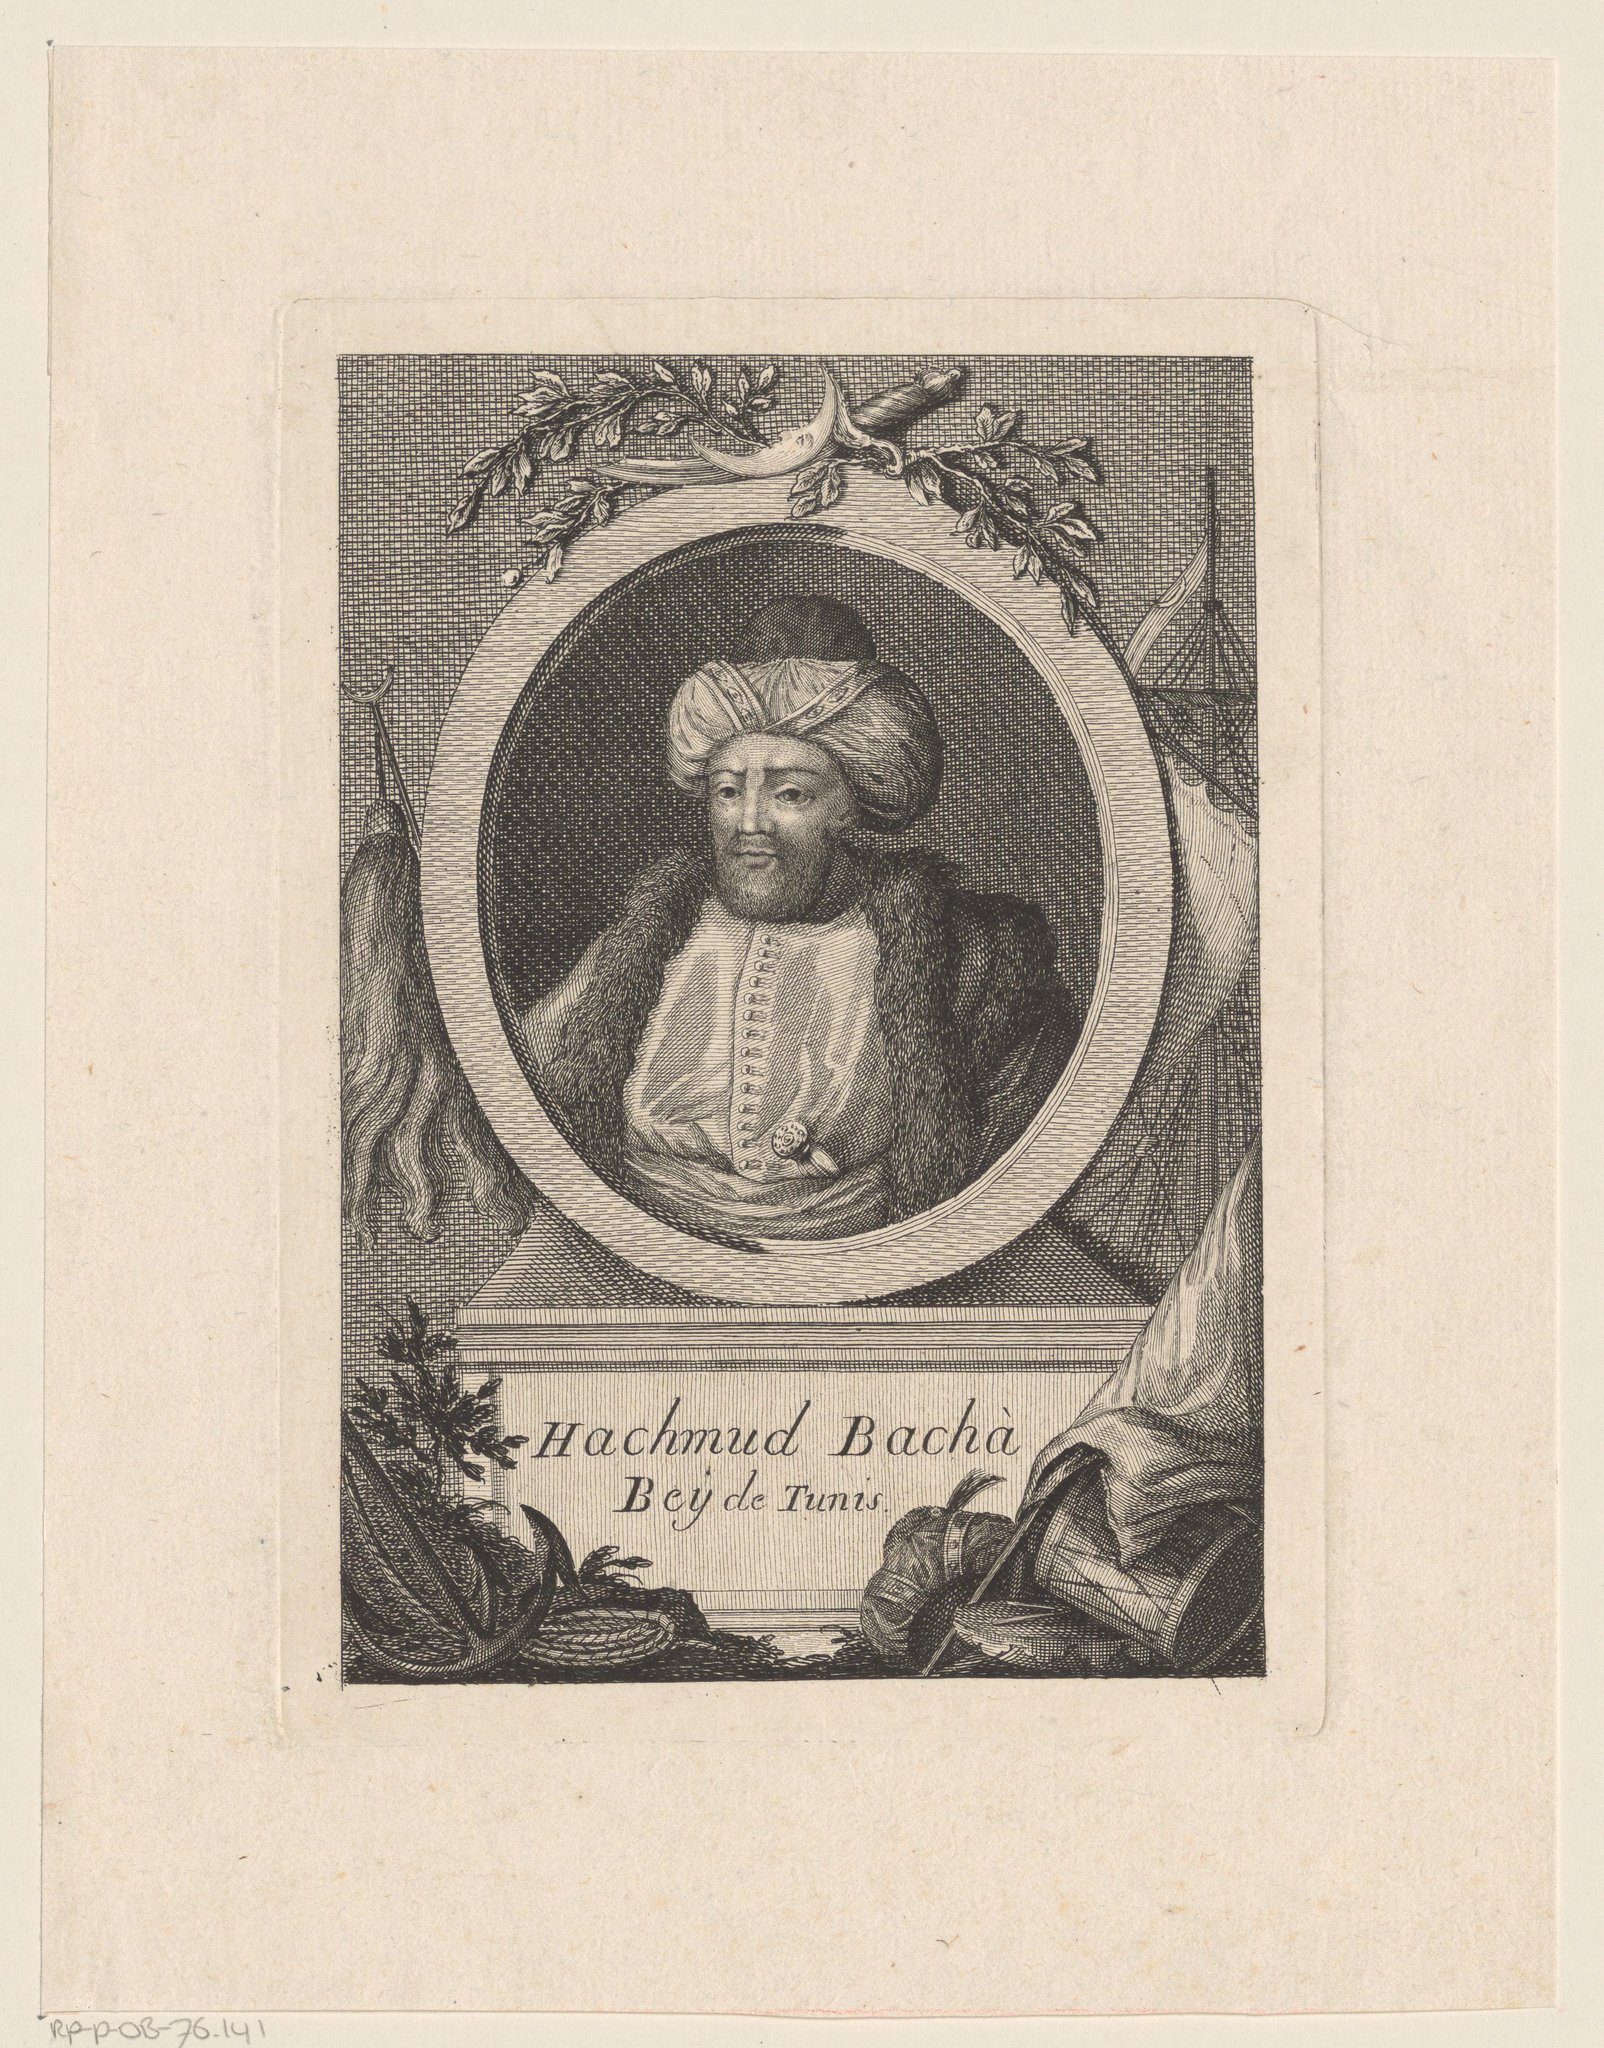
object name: print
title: Portret van Ahmed, bey van Tunis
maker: Anonymous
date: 1837-1899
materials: paper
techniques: engraving, etching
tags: head-gear: turban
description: Portret van Ahmed in een ovale omlijsting. Hij draagt een tulband. Daar omheen een aantal allegorische objecten. In een kader zijn naam en titel.